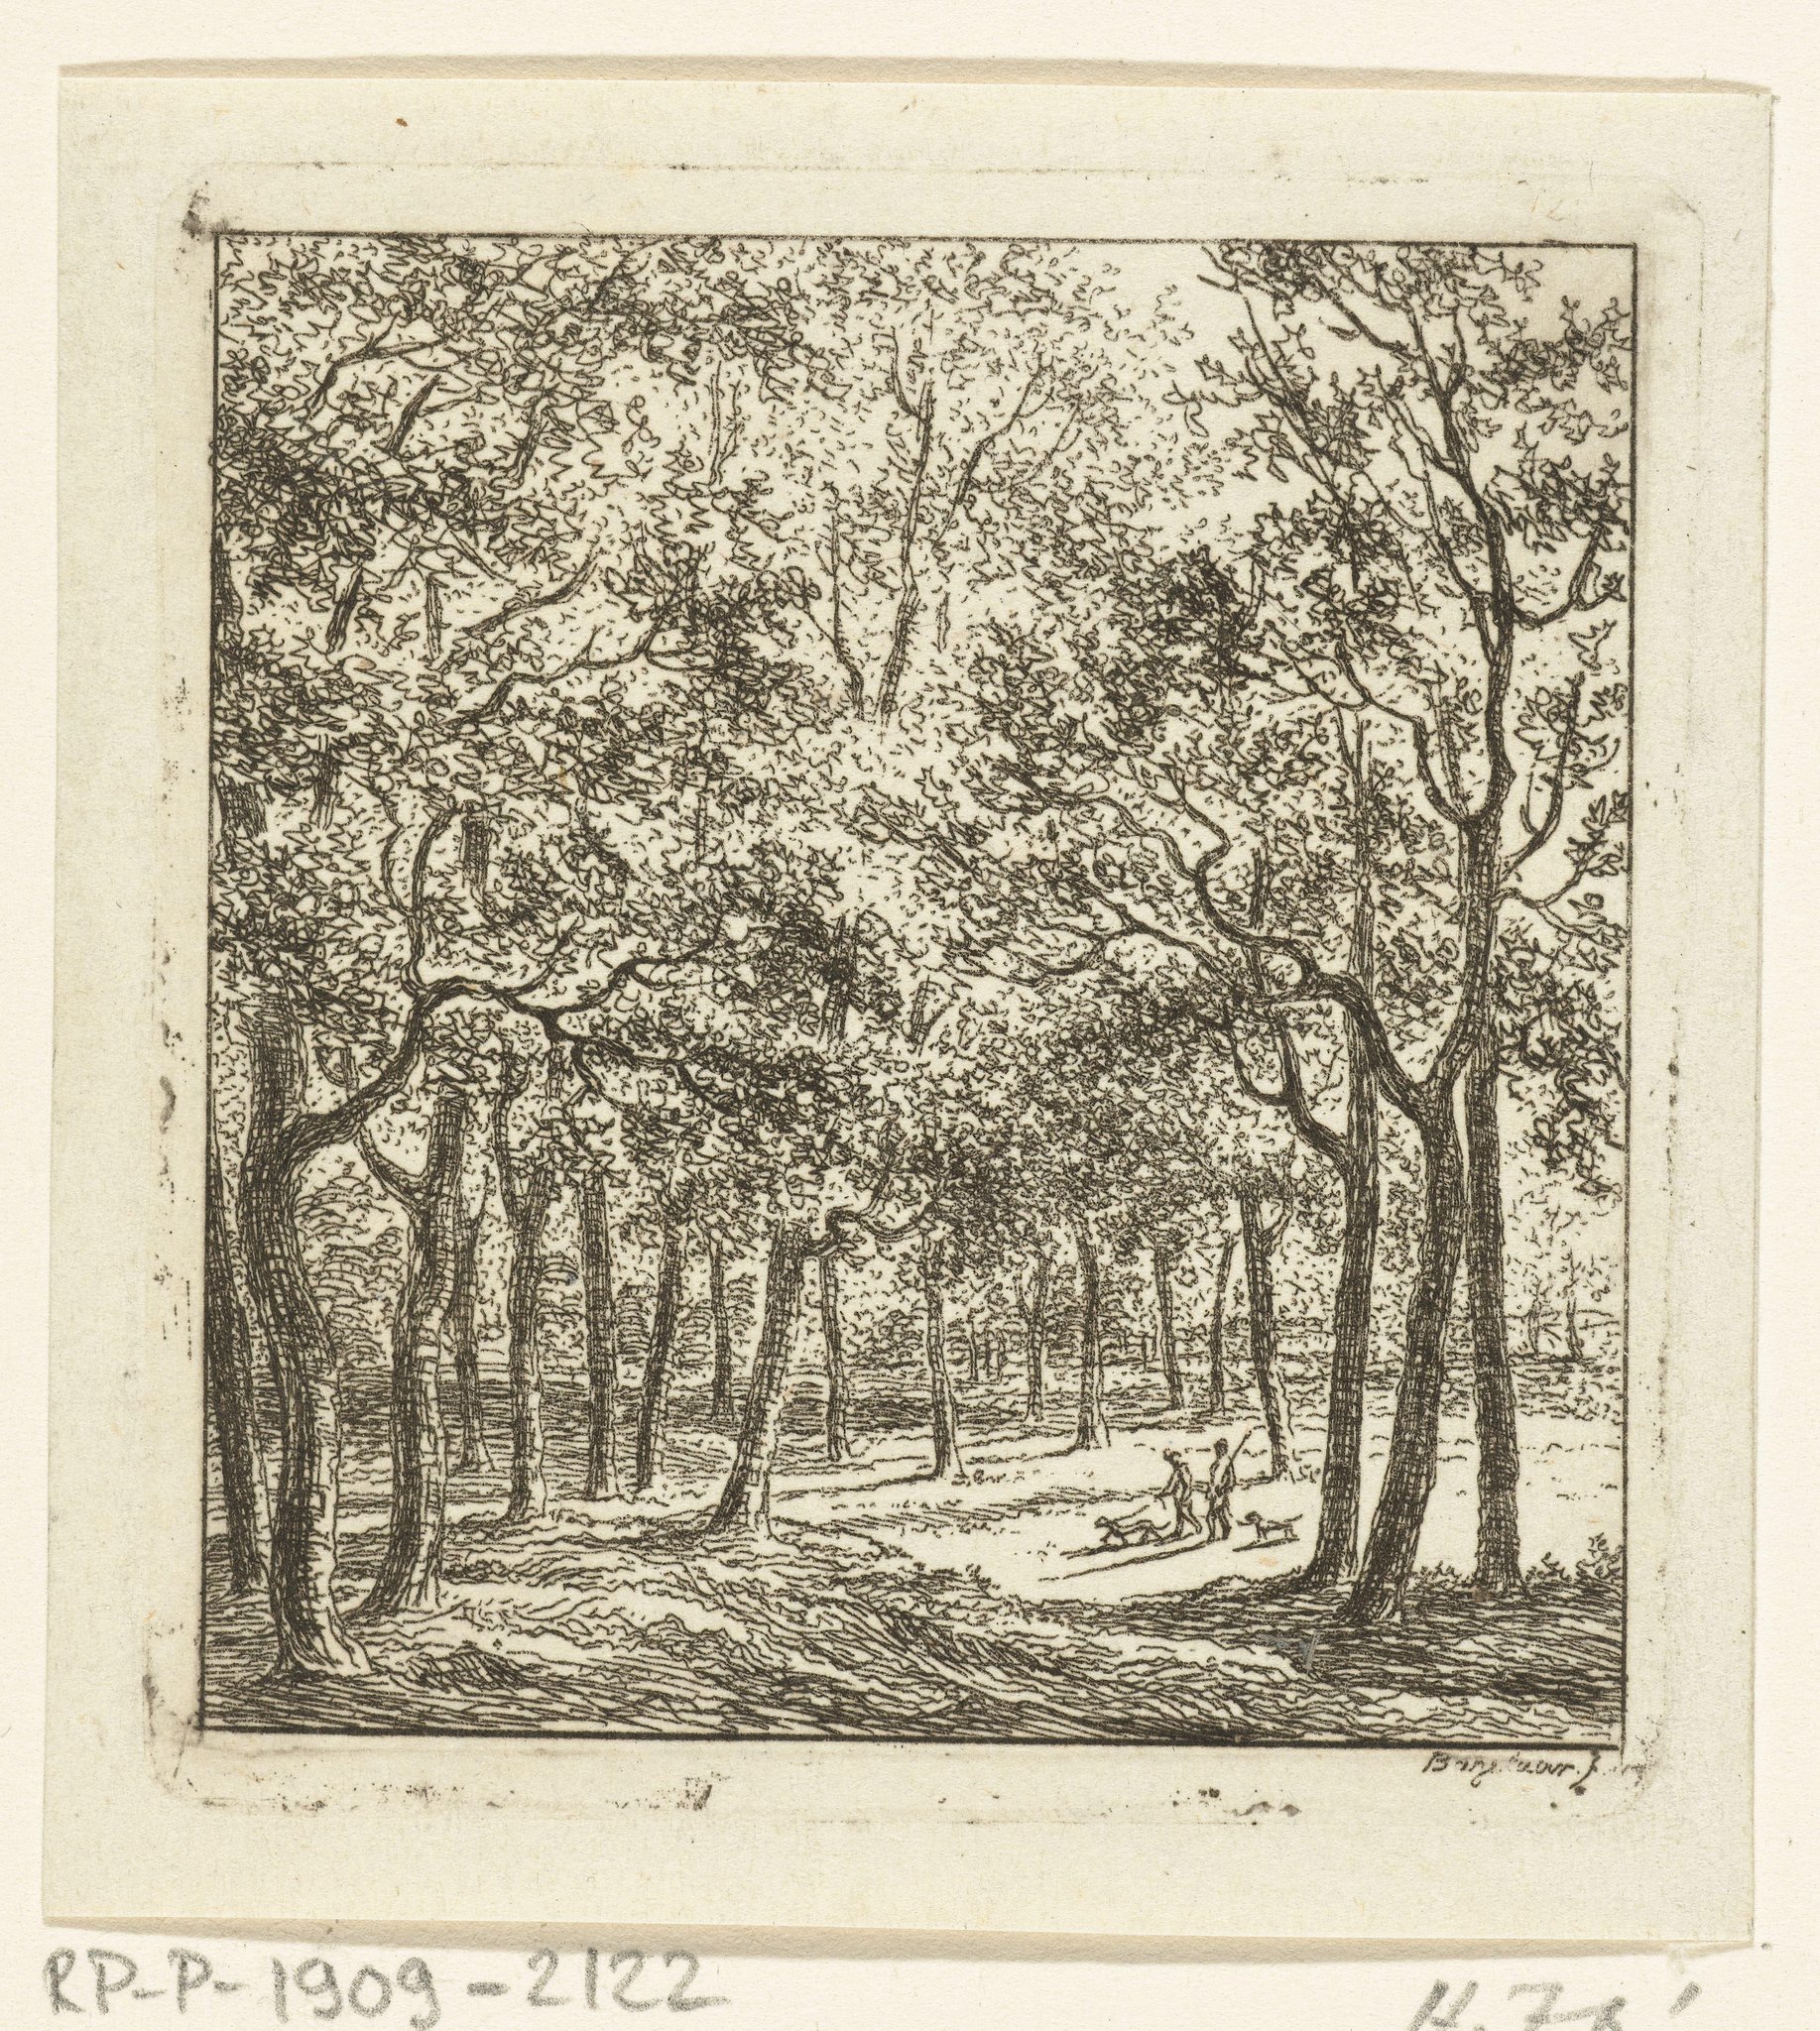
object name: print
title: Twee mannen met honden in het bos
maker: ernst willem jan bagelaar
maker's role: draughtsman, print maker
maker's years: 1775-1837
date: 1798-1837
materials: paper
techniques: etching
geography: netherlands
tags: forest, wood (+ landscape with figures, staffage)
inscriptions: collector's mark: Lugt 2228